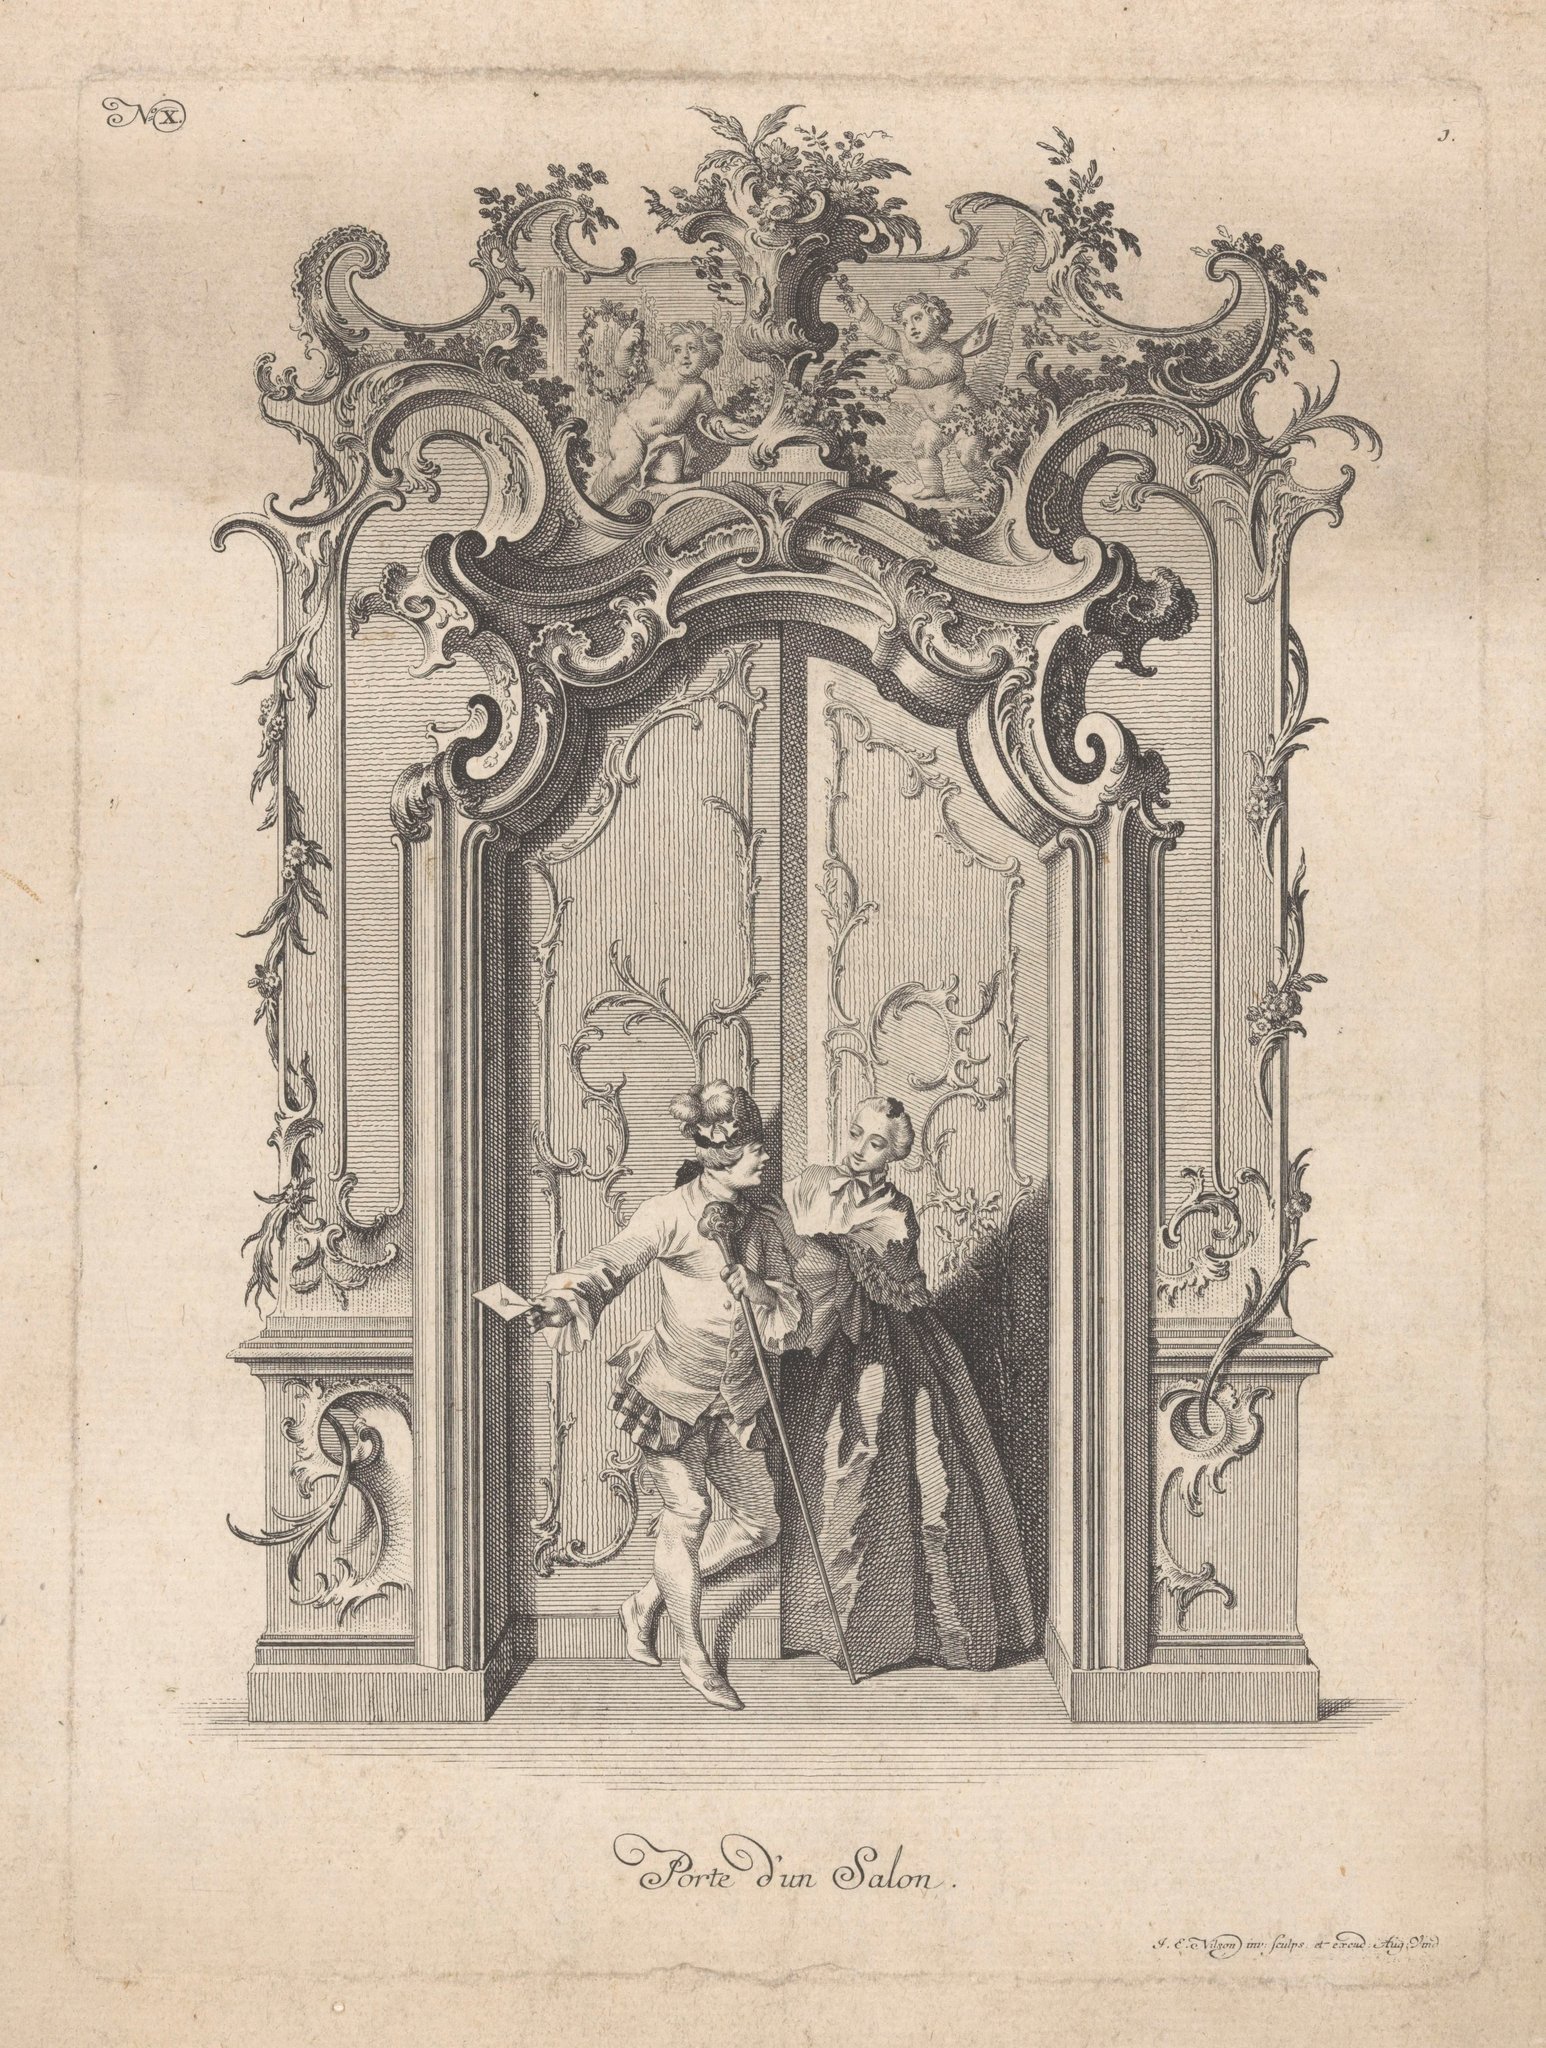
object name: print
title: Interieurdecoraties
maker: johann esaias nilson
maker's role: draughtsman, print maker, publisher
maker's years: 1721-1788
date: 1731-1788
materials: paper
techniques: engraving, etching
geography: augsburg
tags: monumental door, porch, 'aediculum', postman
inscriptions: collector's mark: Lugt 2760, collector's mark: Lugt 2228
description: Voor een rocaille deur met vaas, putti en bloemmotieven staat een bode met een staf en een brief. Rechts staat een vrouw in de deuropening. Uitgeversnummer X.